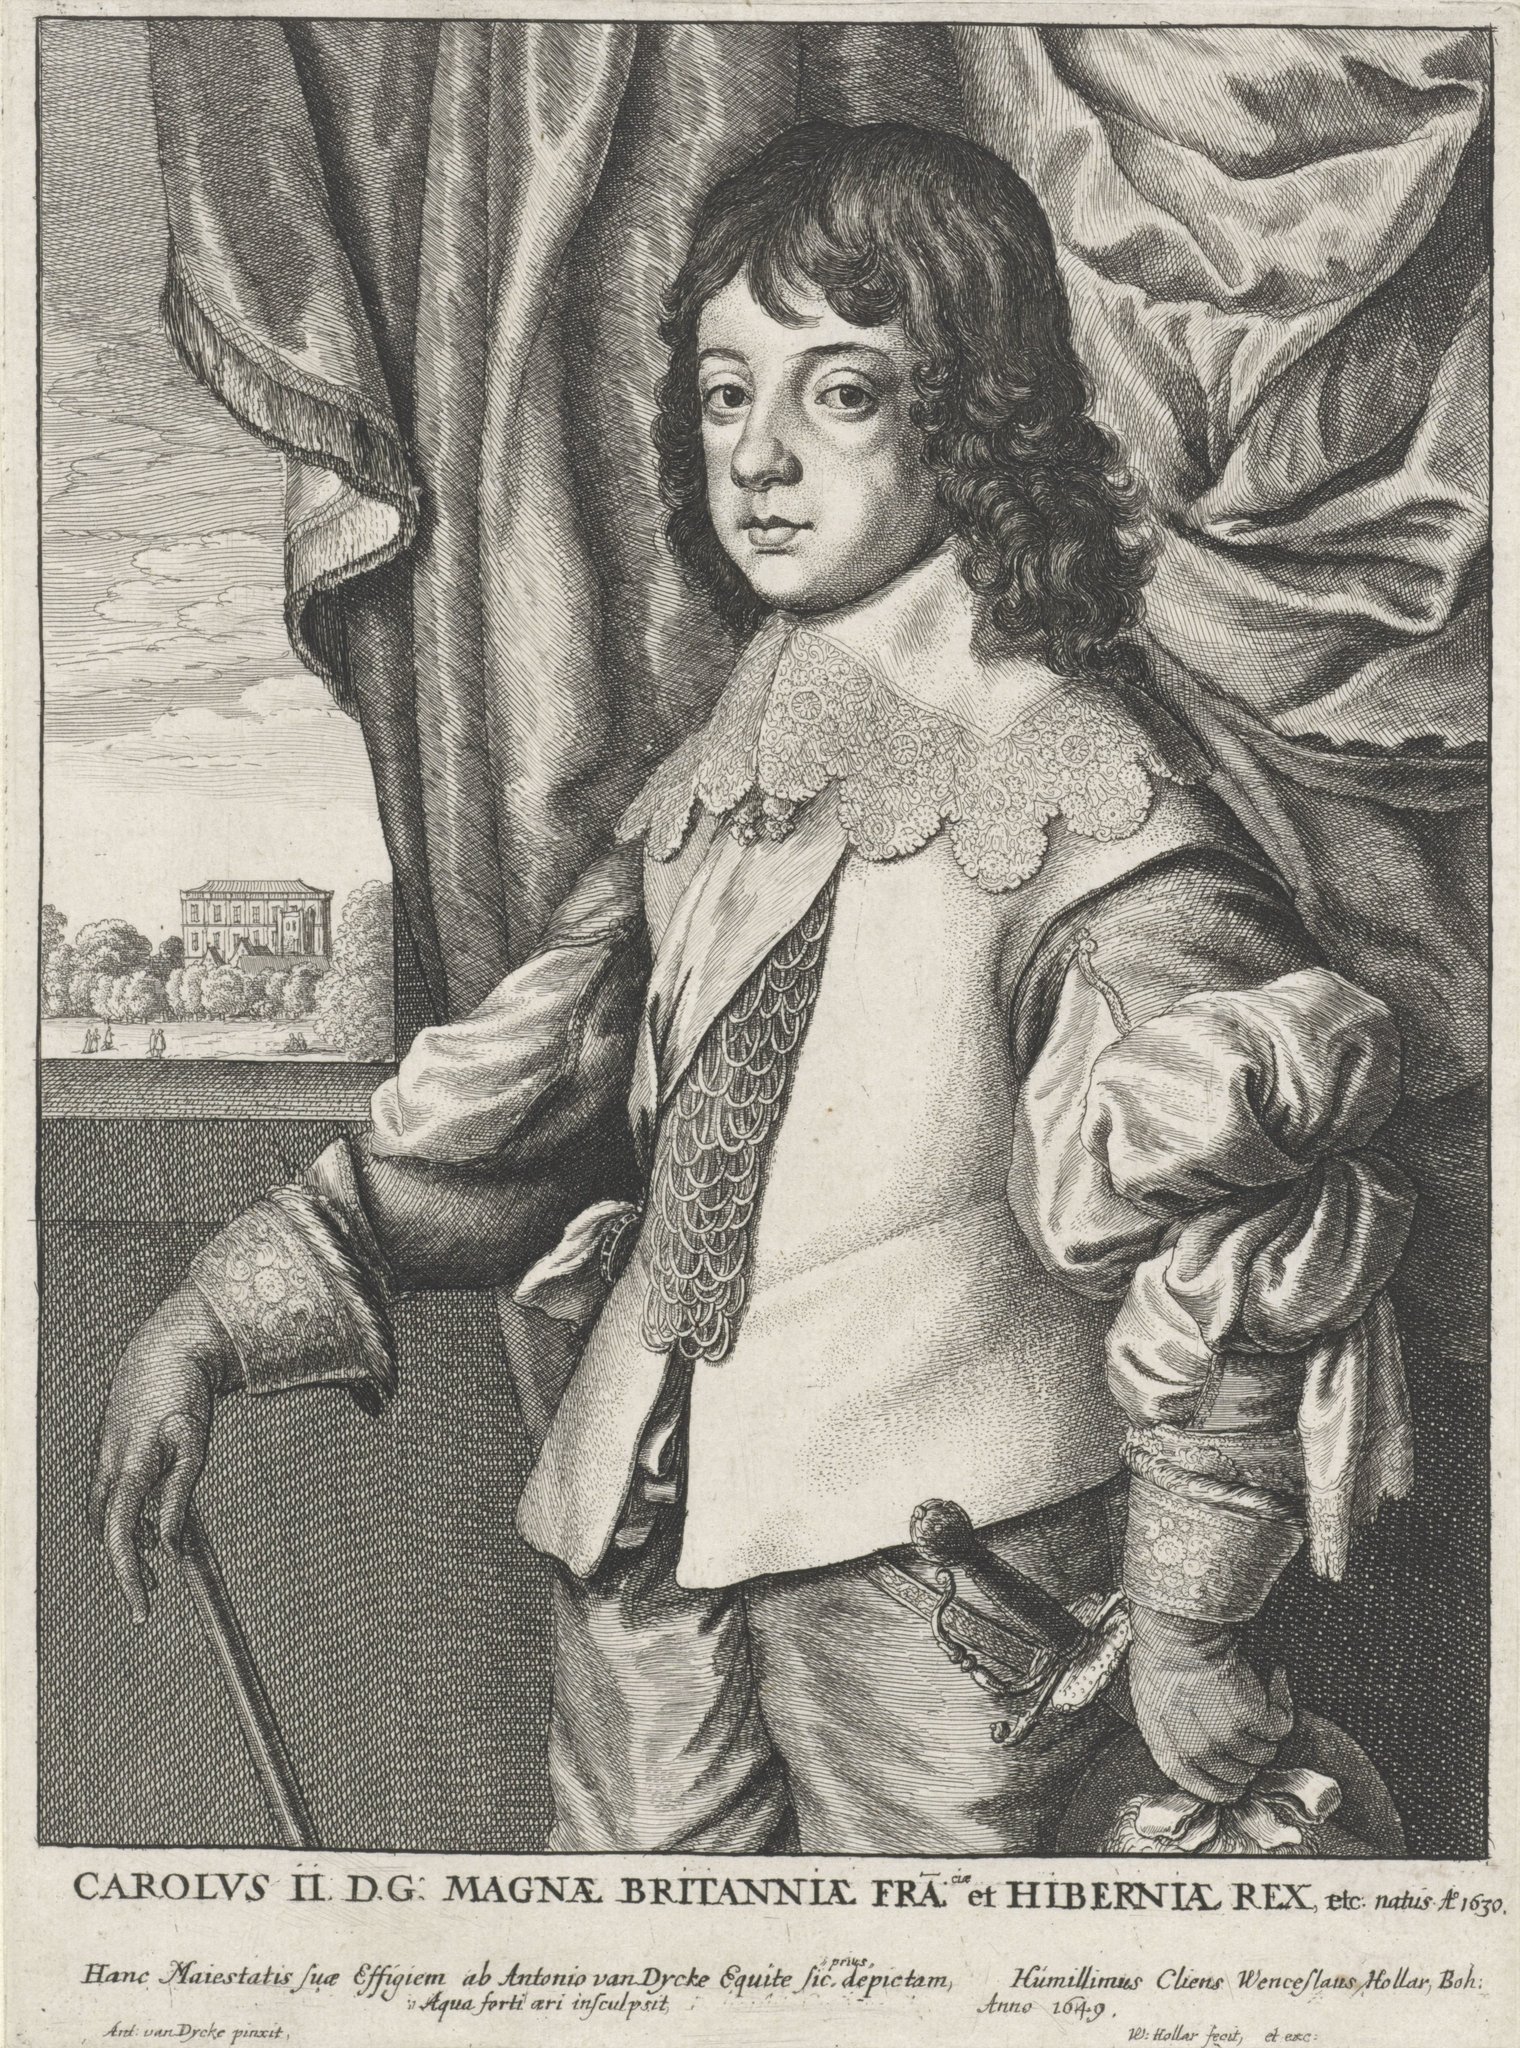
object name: print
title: Portret van Karel Stuart, prins van Wales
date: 1649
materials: paper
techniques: etching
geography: antwerp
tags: karel ii (koning van engeland)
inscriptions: collector's mark: Lugt 240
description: Portret van Karel Stuart, prins van Wales, de latere koning Karel II van Engeland.